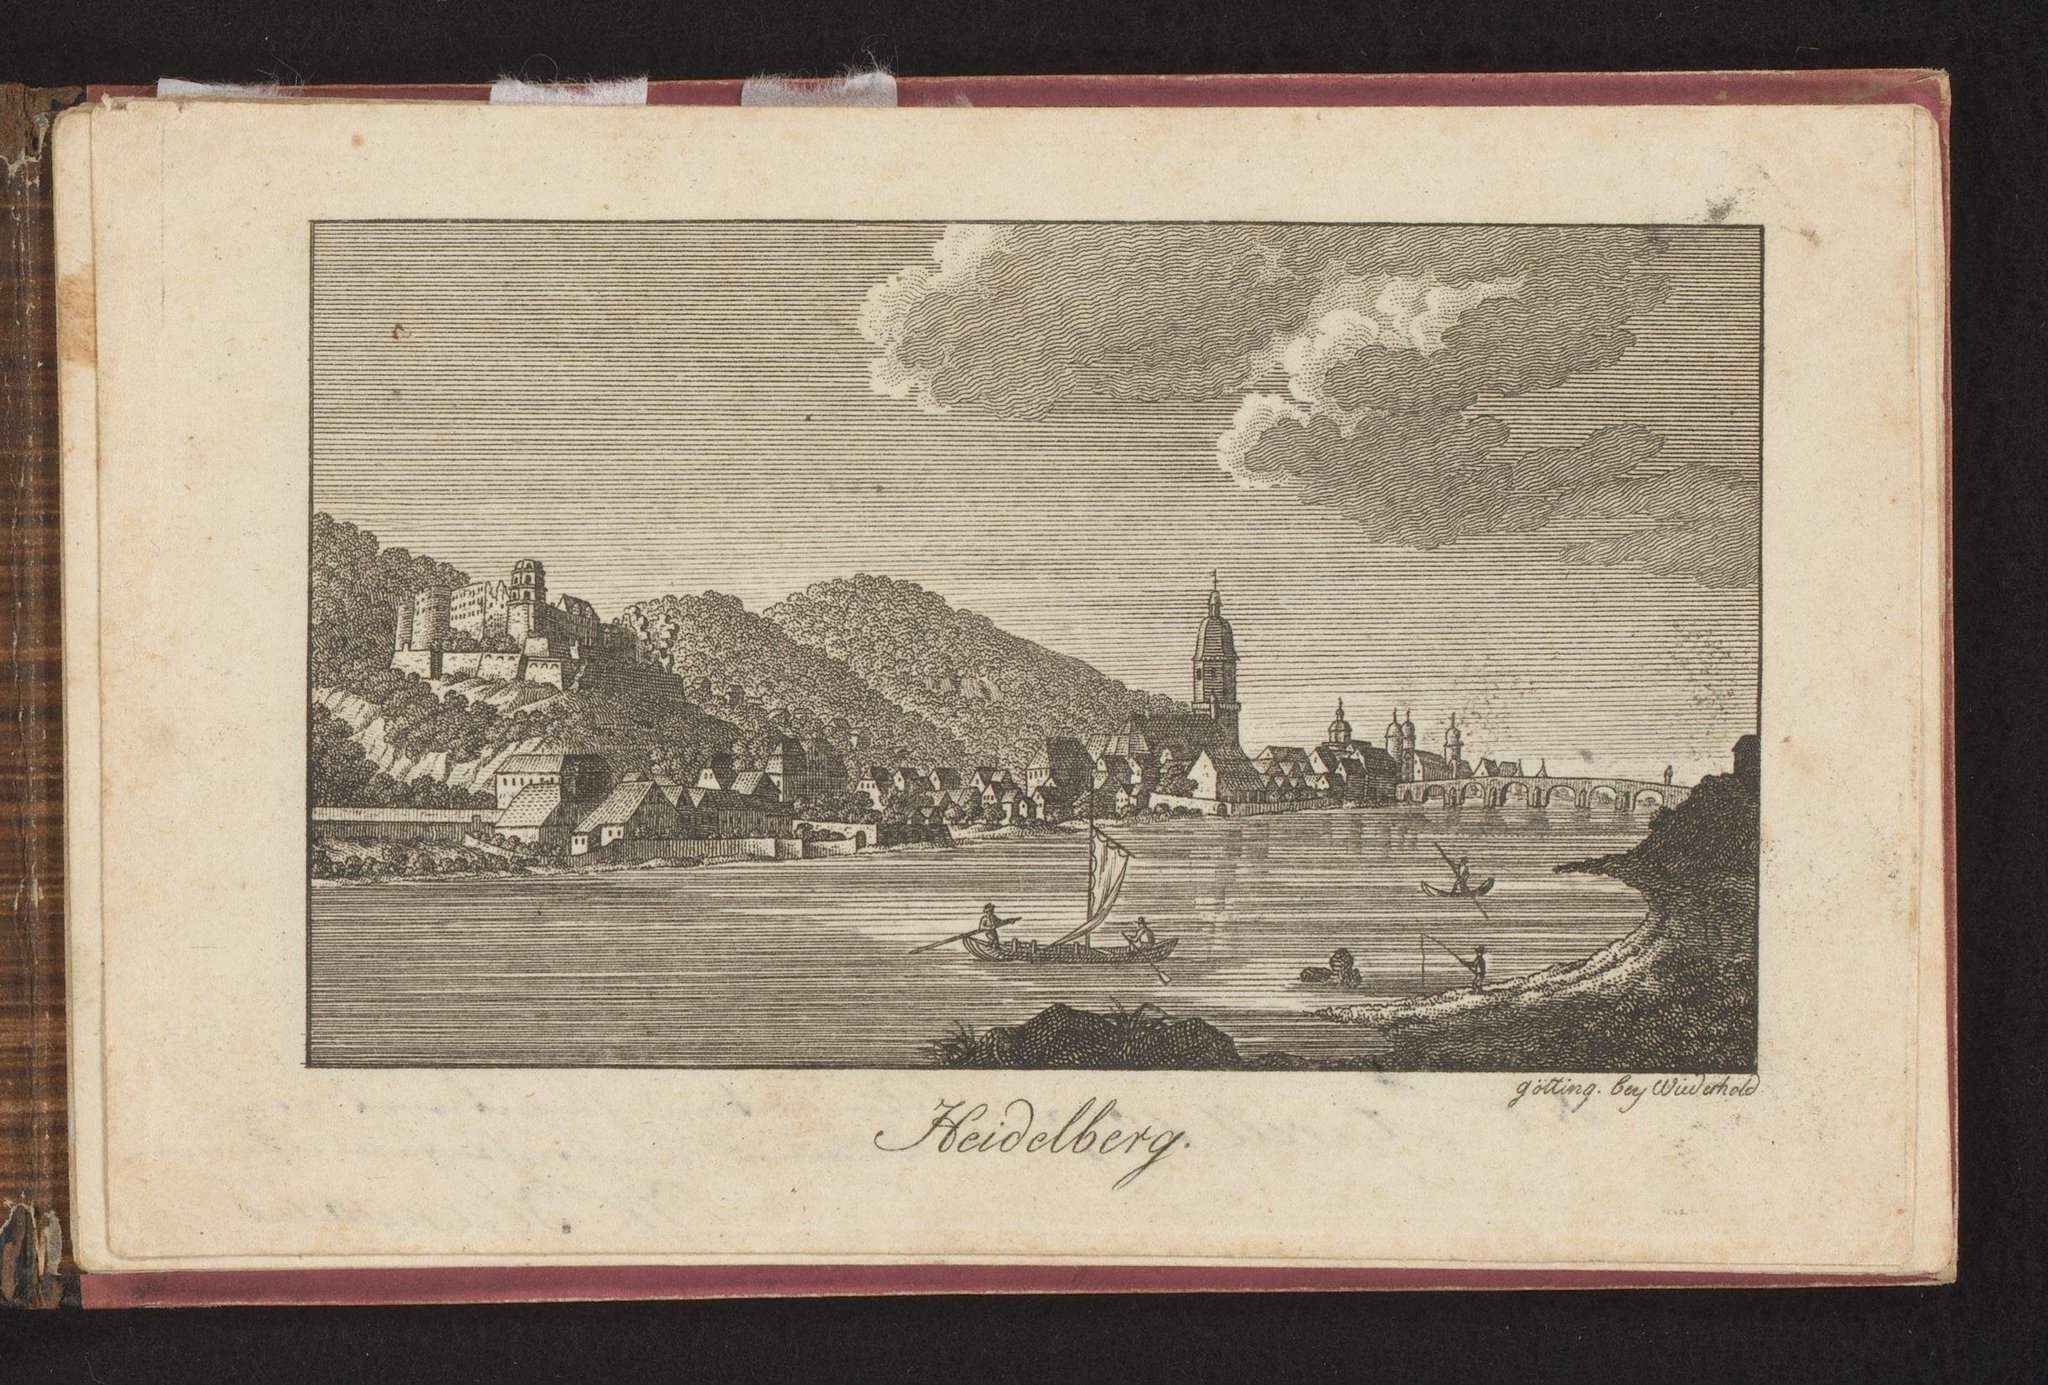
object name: print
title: Heidelberg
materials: ink, paper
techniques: etching, writing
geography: gottingen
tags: 'album amicorum', 'stammbuch', river (+ landscape with figures, staffage), city-view in general; 'veduta' (+ city(-scape) with figures, staffage)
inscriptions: tekst, verso, handgeschreven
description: Handgeschreven tekst in het Duits op het verso.